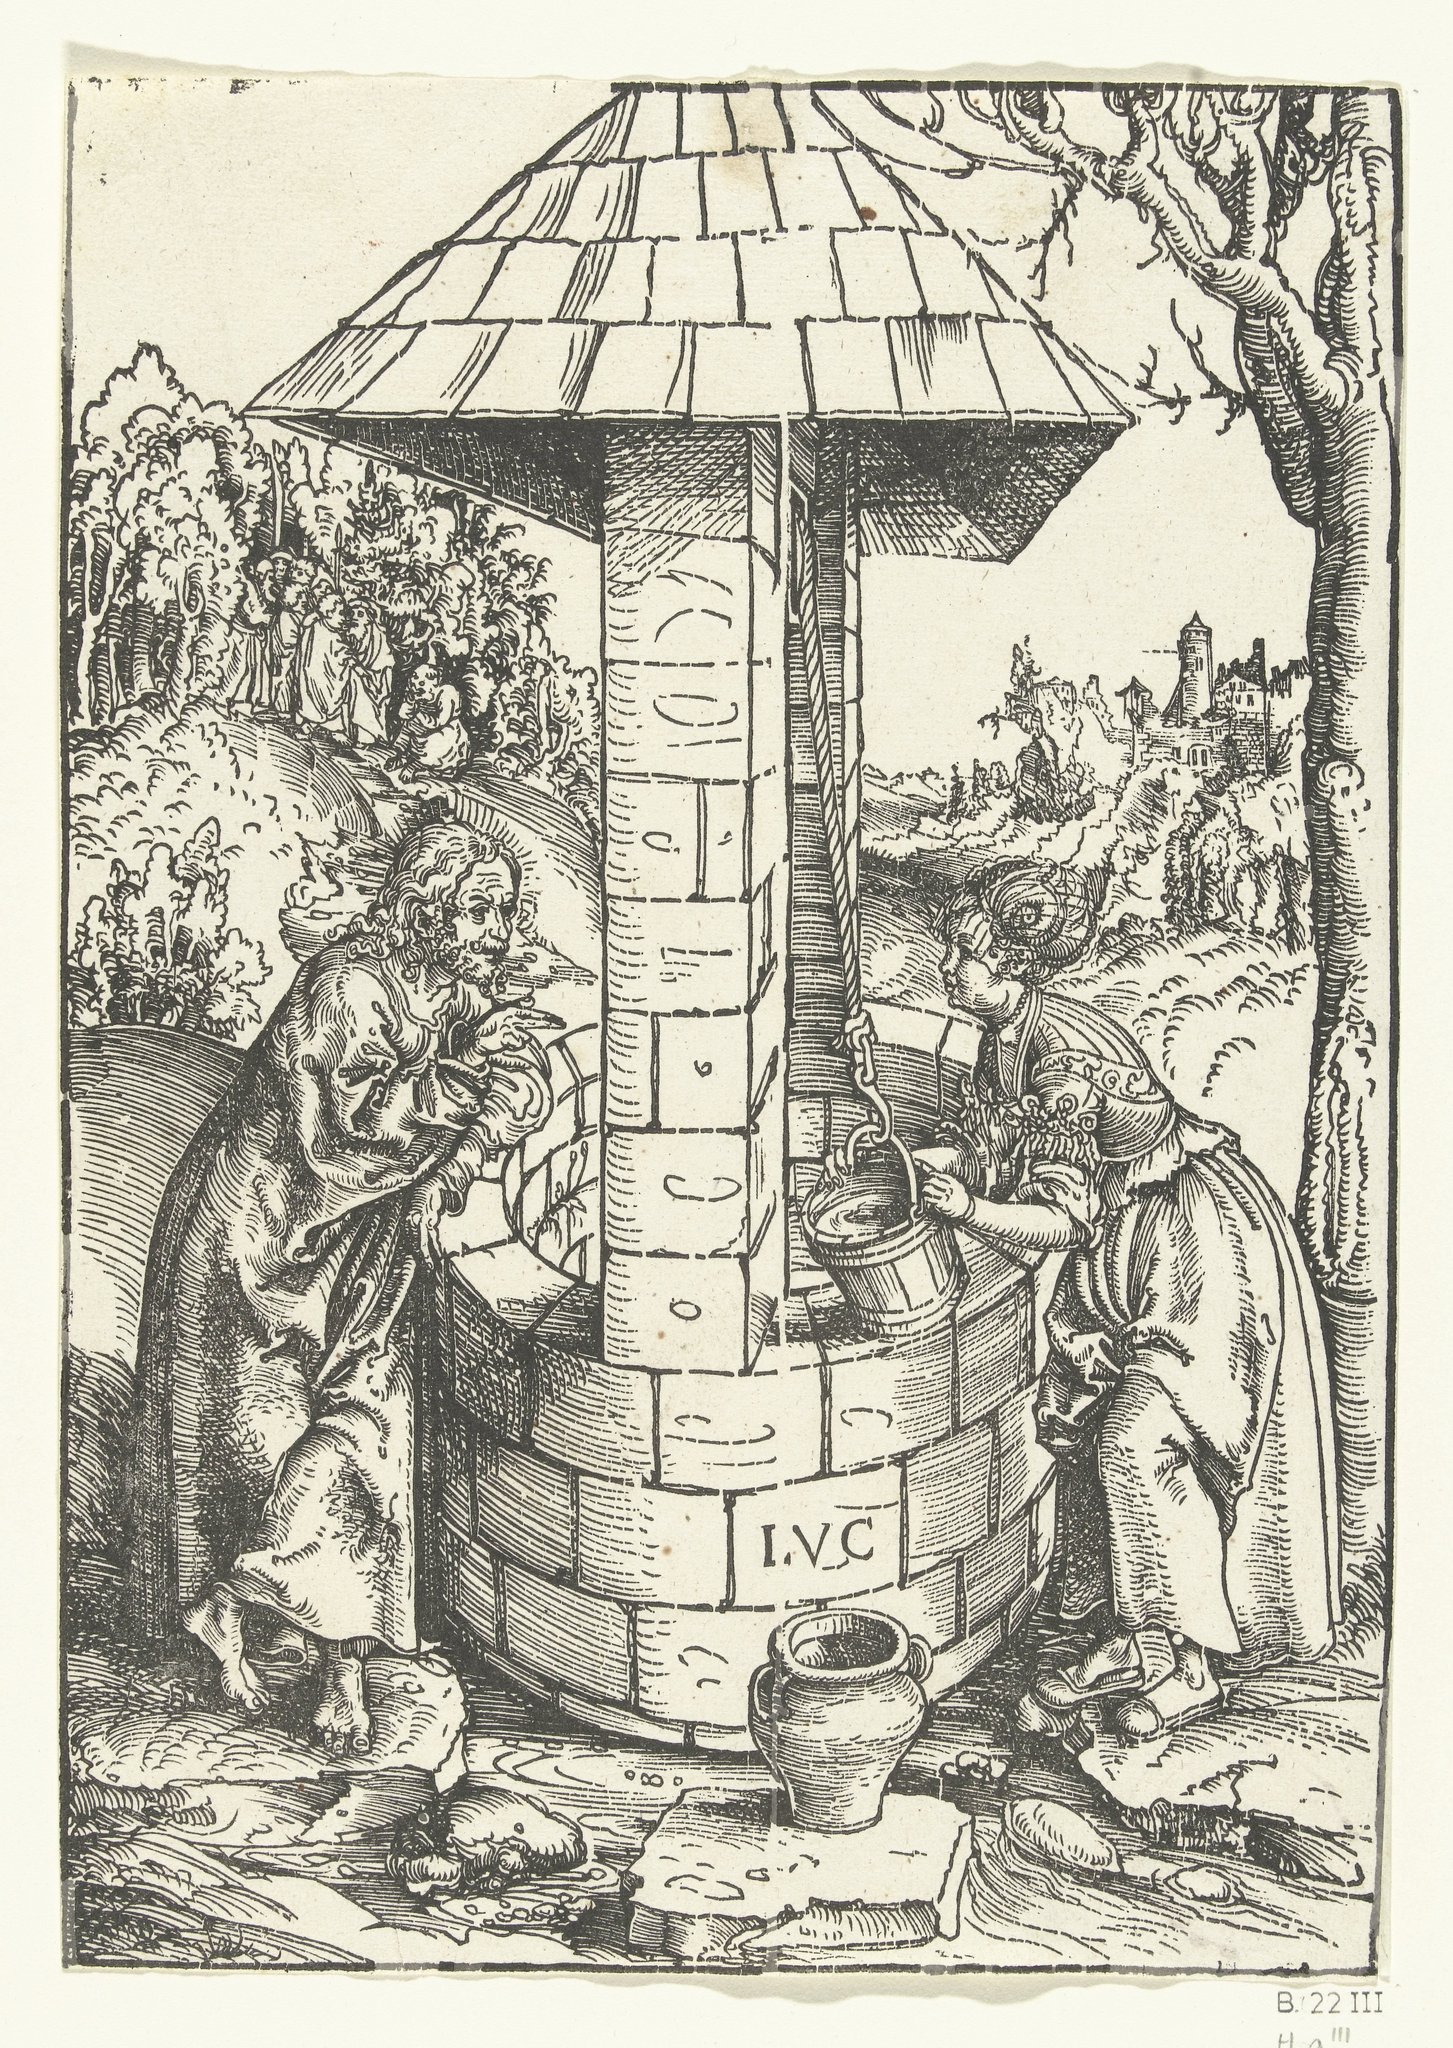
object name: print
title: Christus en de Samaritaanse vrouw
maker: lucas cranach (i)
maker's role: draughtsman, print maker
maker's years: 1472-1553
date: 1482-1553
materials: paper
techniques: woodcut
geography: germany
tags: christ and the woman of samaria: sitting at jacob's well he asks her for a drink from her jug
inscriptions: collector's mark: Lugt 240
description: Een vrouw put water bij de bron van Jakob. Christus vraagt haar of hij wat mag drinken. Zijn discipelen die samen met hem reizen lopen in de verte op een pad. Op deze druk van het houtblok zijn de schilden met het keurvorstelijk en hertogelijk wapen op het dak boven de put verdwenen.